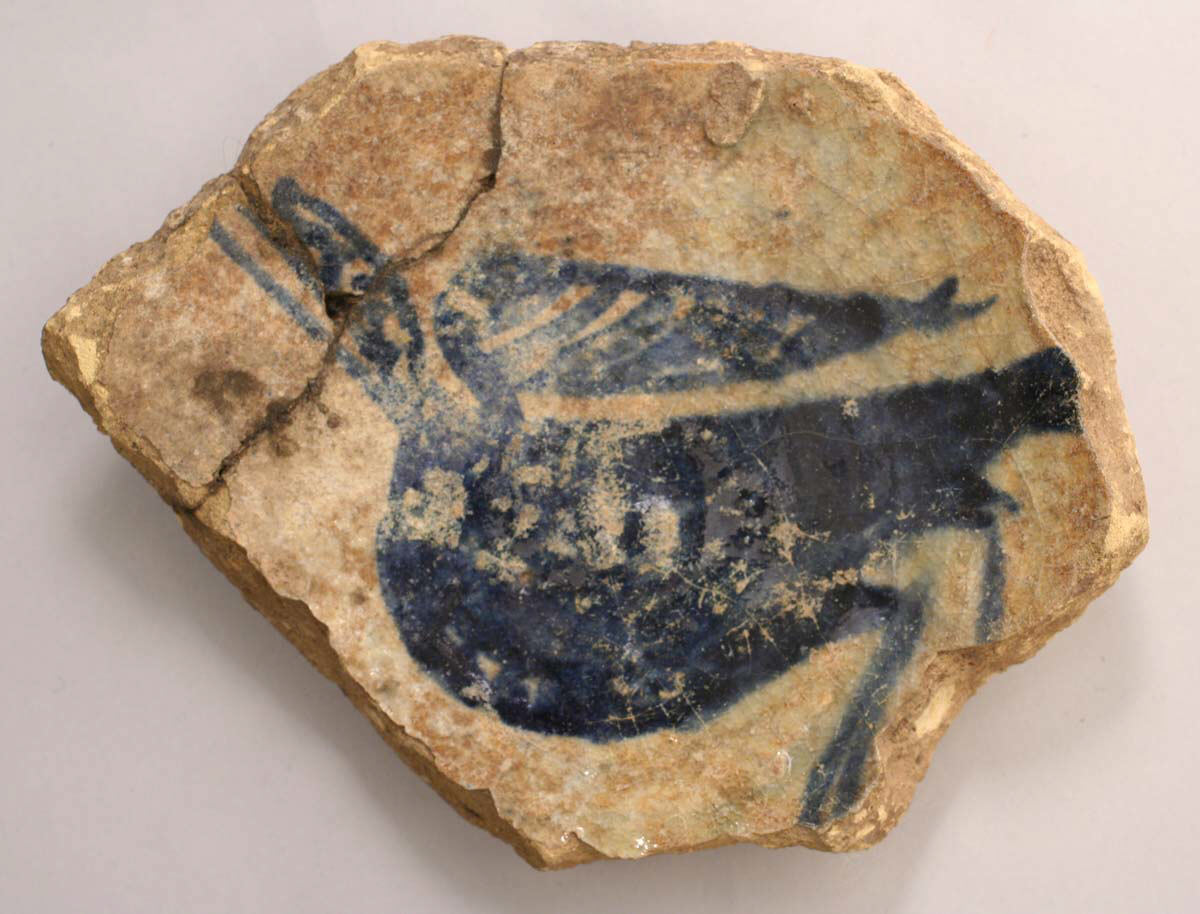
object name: ceramic fragment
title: Fragment of Dish with Bird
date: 1301-1500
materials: glaze, stonepaste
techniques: painting, underglaze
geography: egypt or syria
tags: birds